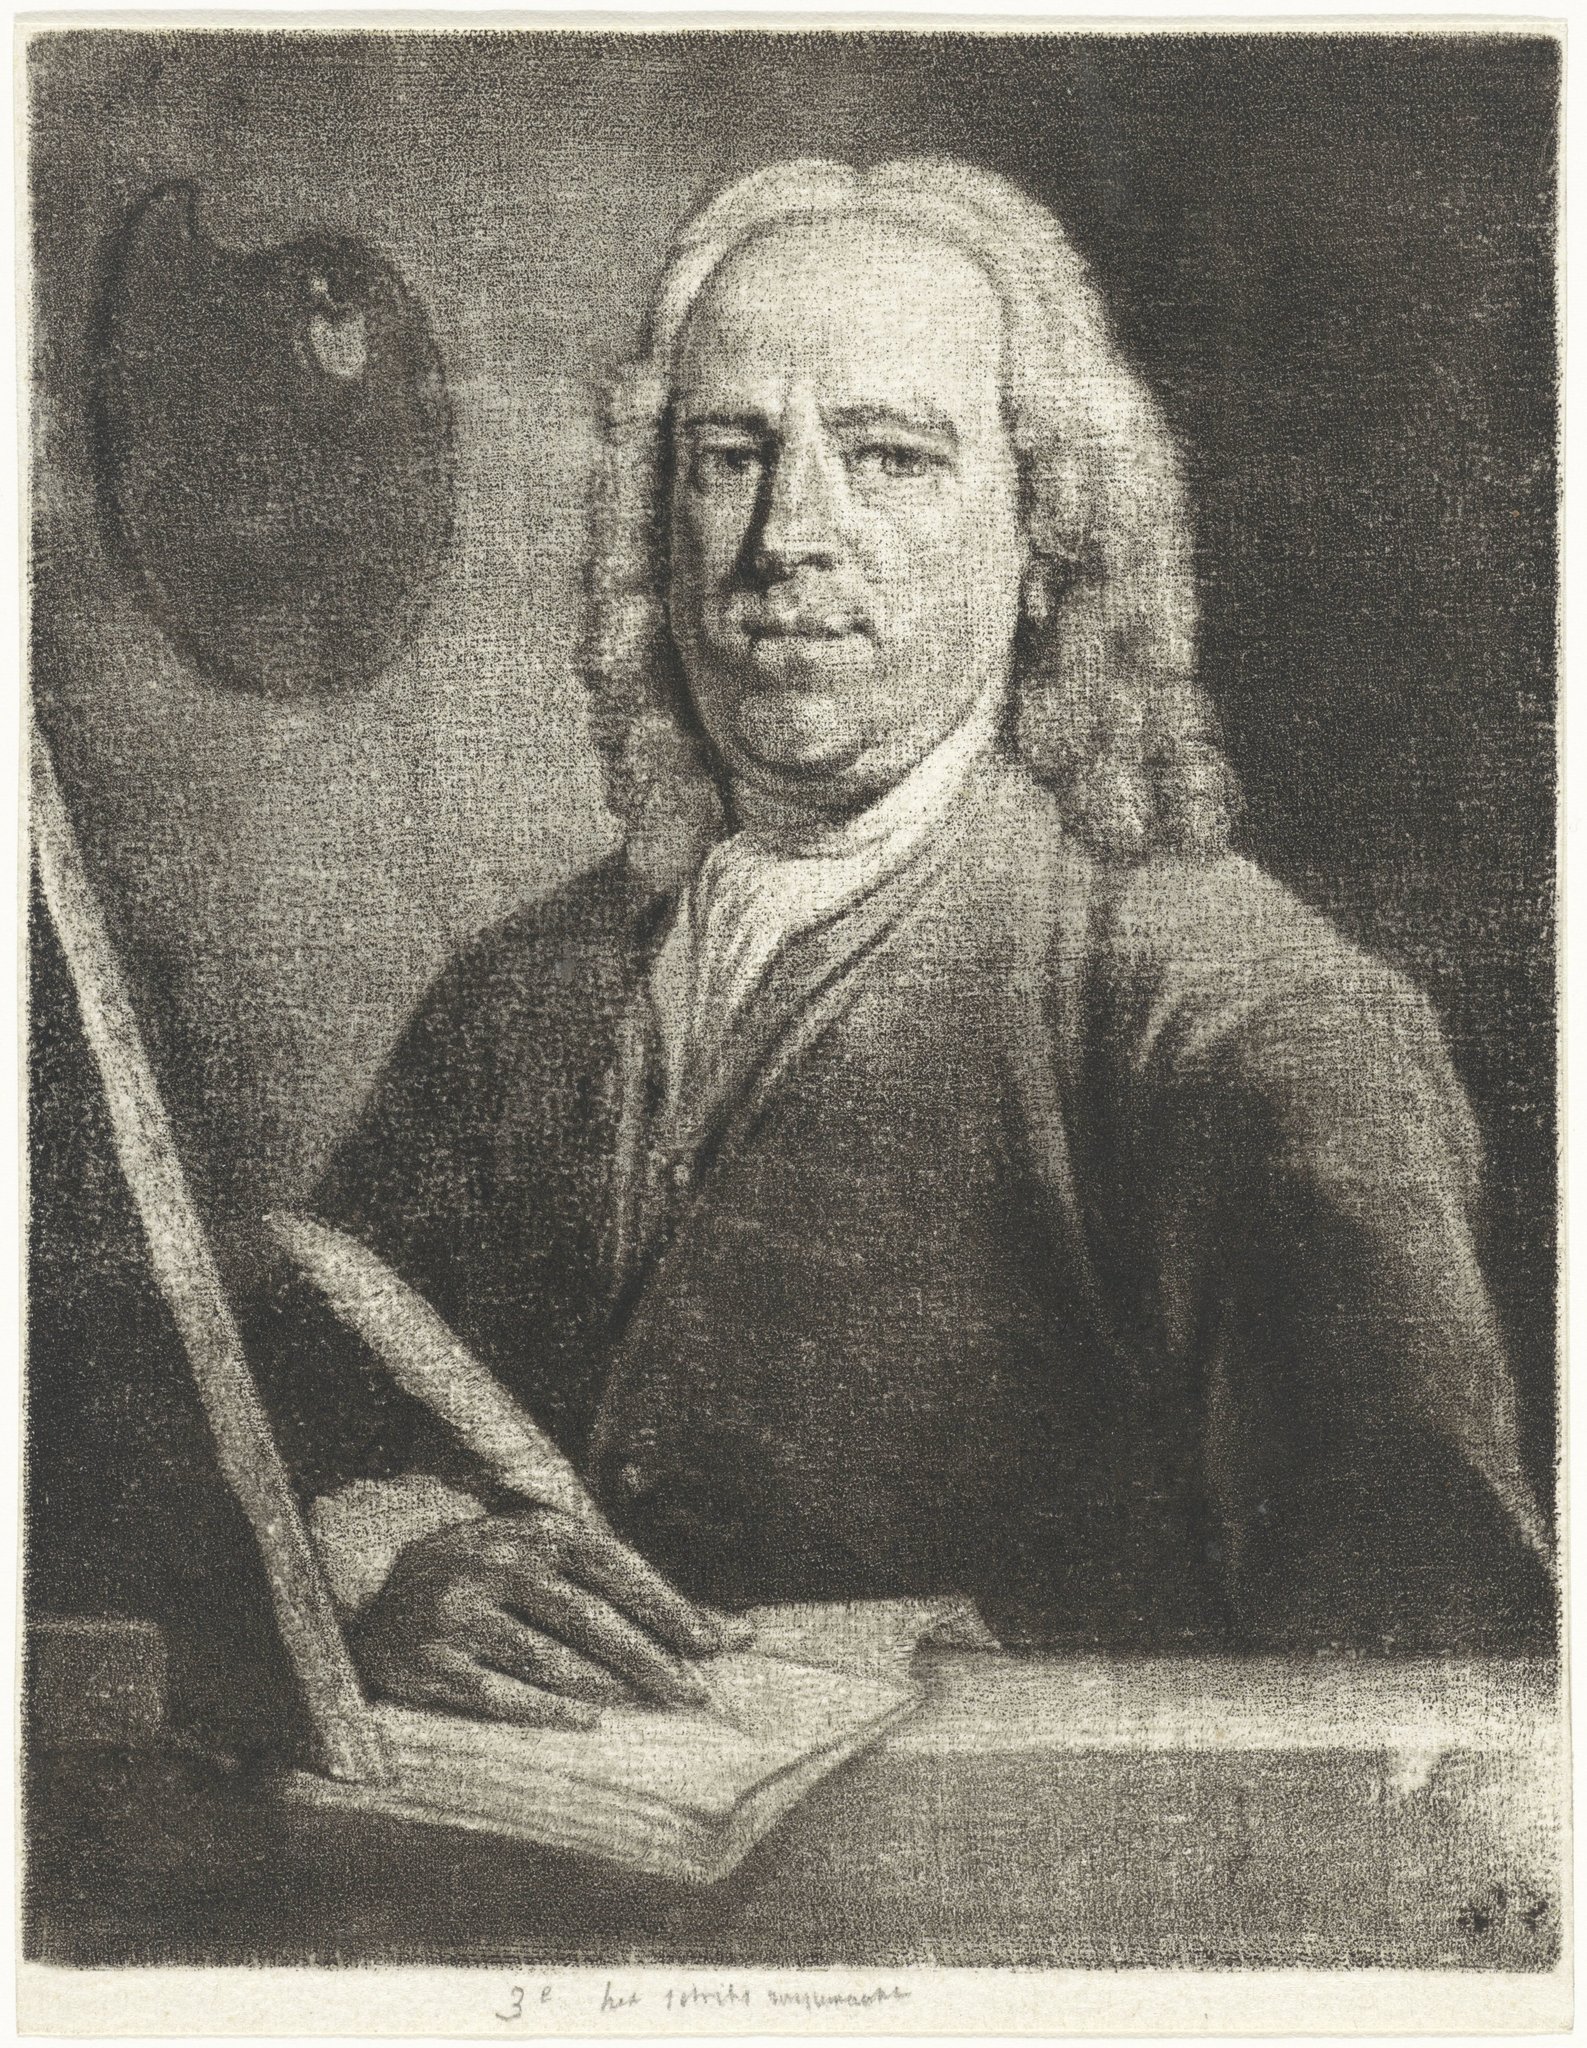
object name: print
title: Portret van Gerard Hoet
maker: aert schouman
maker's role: draughtsman, painter, print maker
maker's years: 1710-1792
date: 1768-1792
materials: paper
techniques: mezzotint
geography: the hague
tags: painter, print maker, draughtsman, gerard hoet (i), quill, portrait, self-portrait of painter, tools, implements of painter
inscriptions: collector's mark: Lugt 2228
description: De schilder en prentmaker Gerard Hoet maakt notities. Voor hem een paneel en aan de muur een palet.